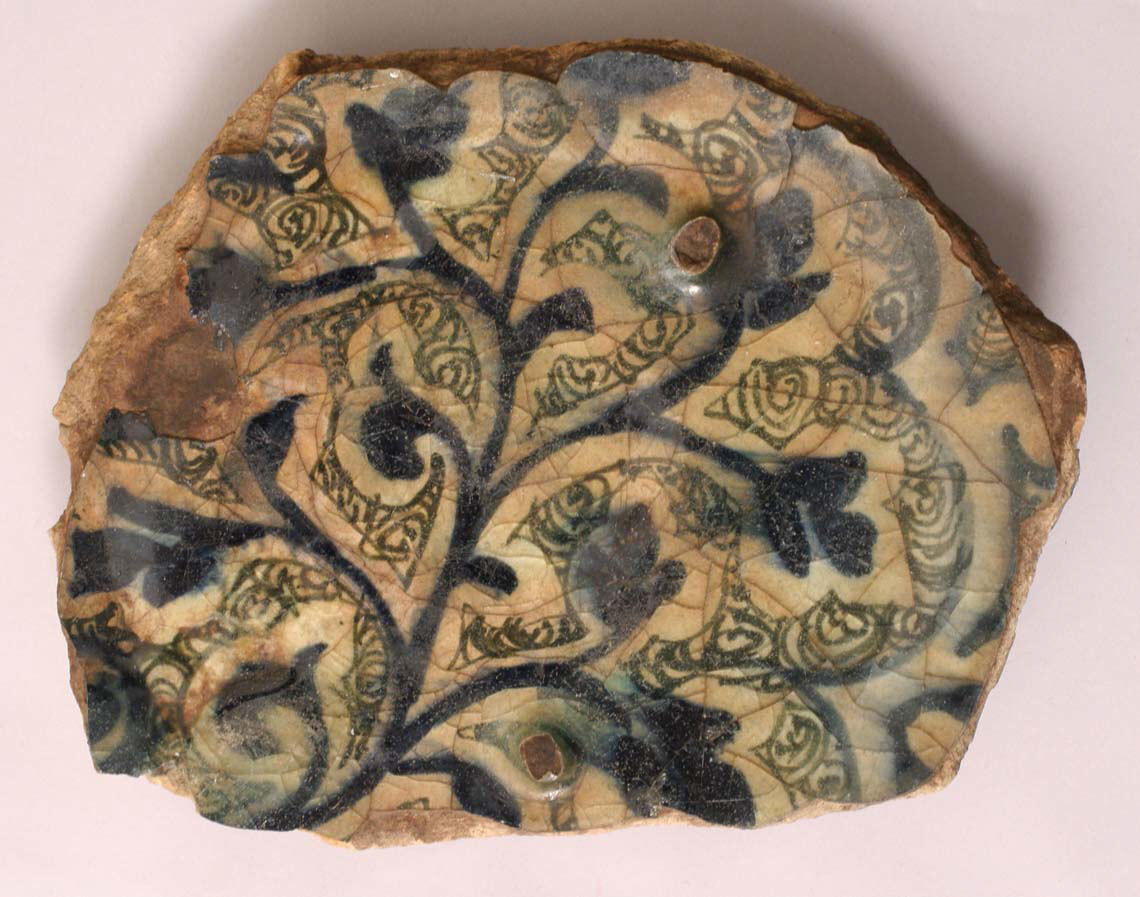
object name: fragment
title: Fragment of a Lamp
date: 1301-1500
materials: glaze, stonepaste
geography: egypt or syria